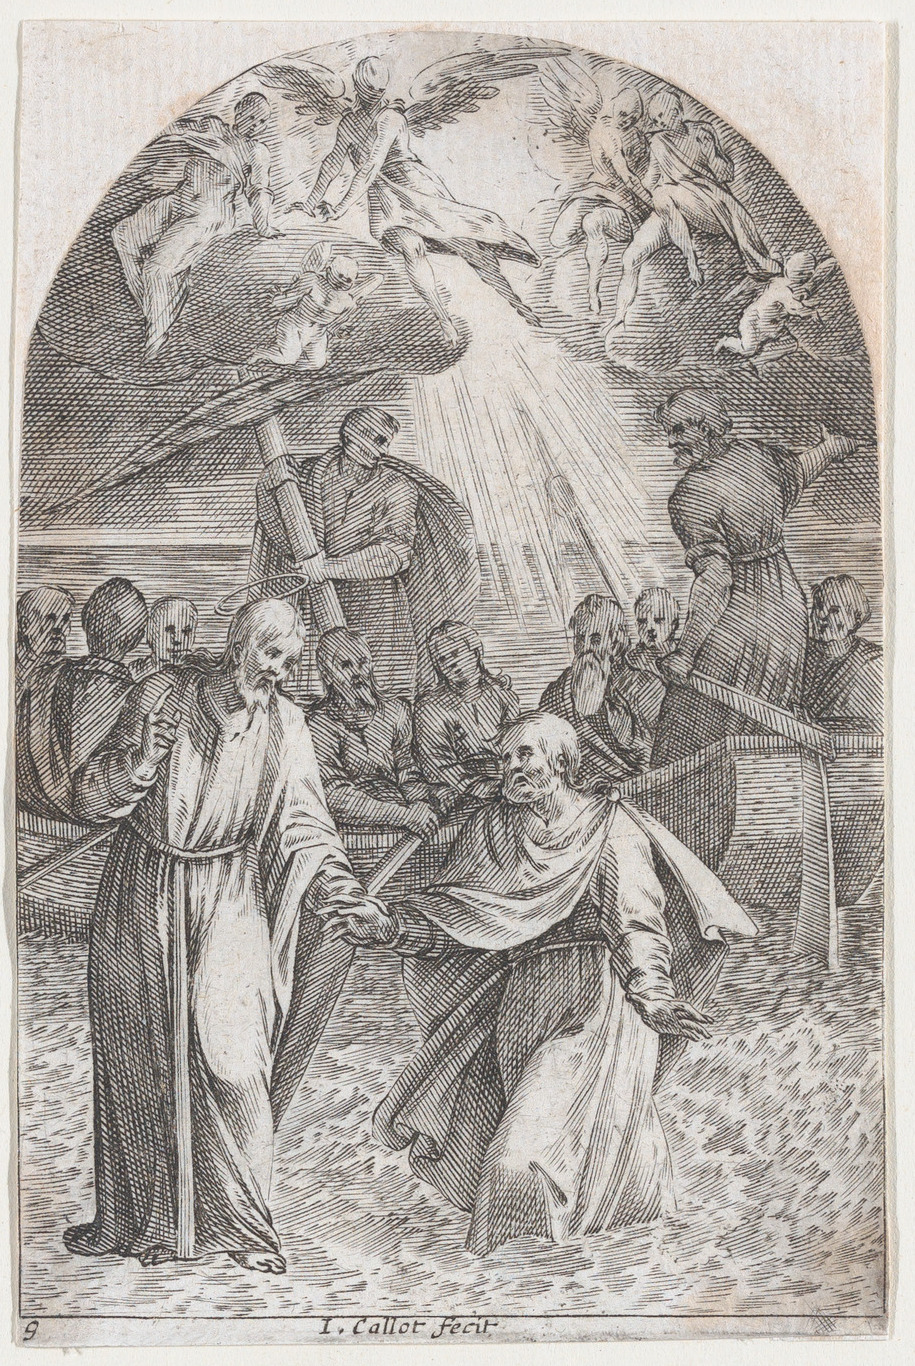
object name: print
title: Christ Walking on Water, Holding the Hand of St. Peter (Second Composition), plate 9 from "Les Tableaux de Rome, Les Eglises Jubilaires" (The Paintings of Rome, The Churches Jubilee)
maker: jacques callot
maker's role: artist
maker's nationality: french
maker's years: 1592-1635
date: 1607-1611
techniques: engraving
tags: angels,christ,saint peter,boats